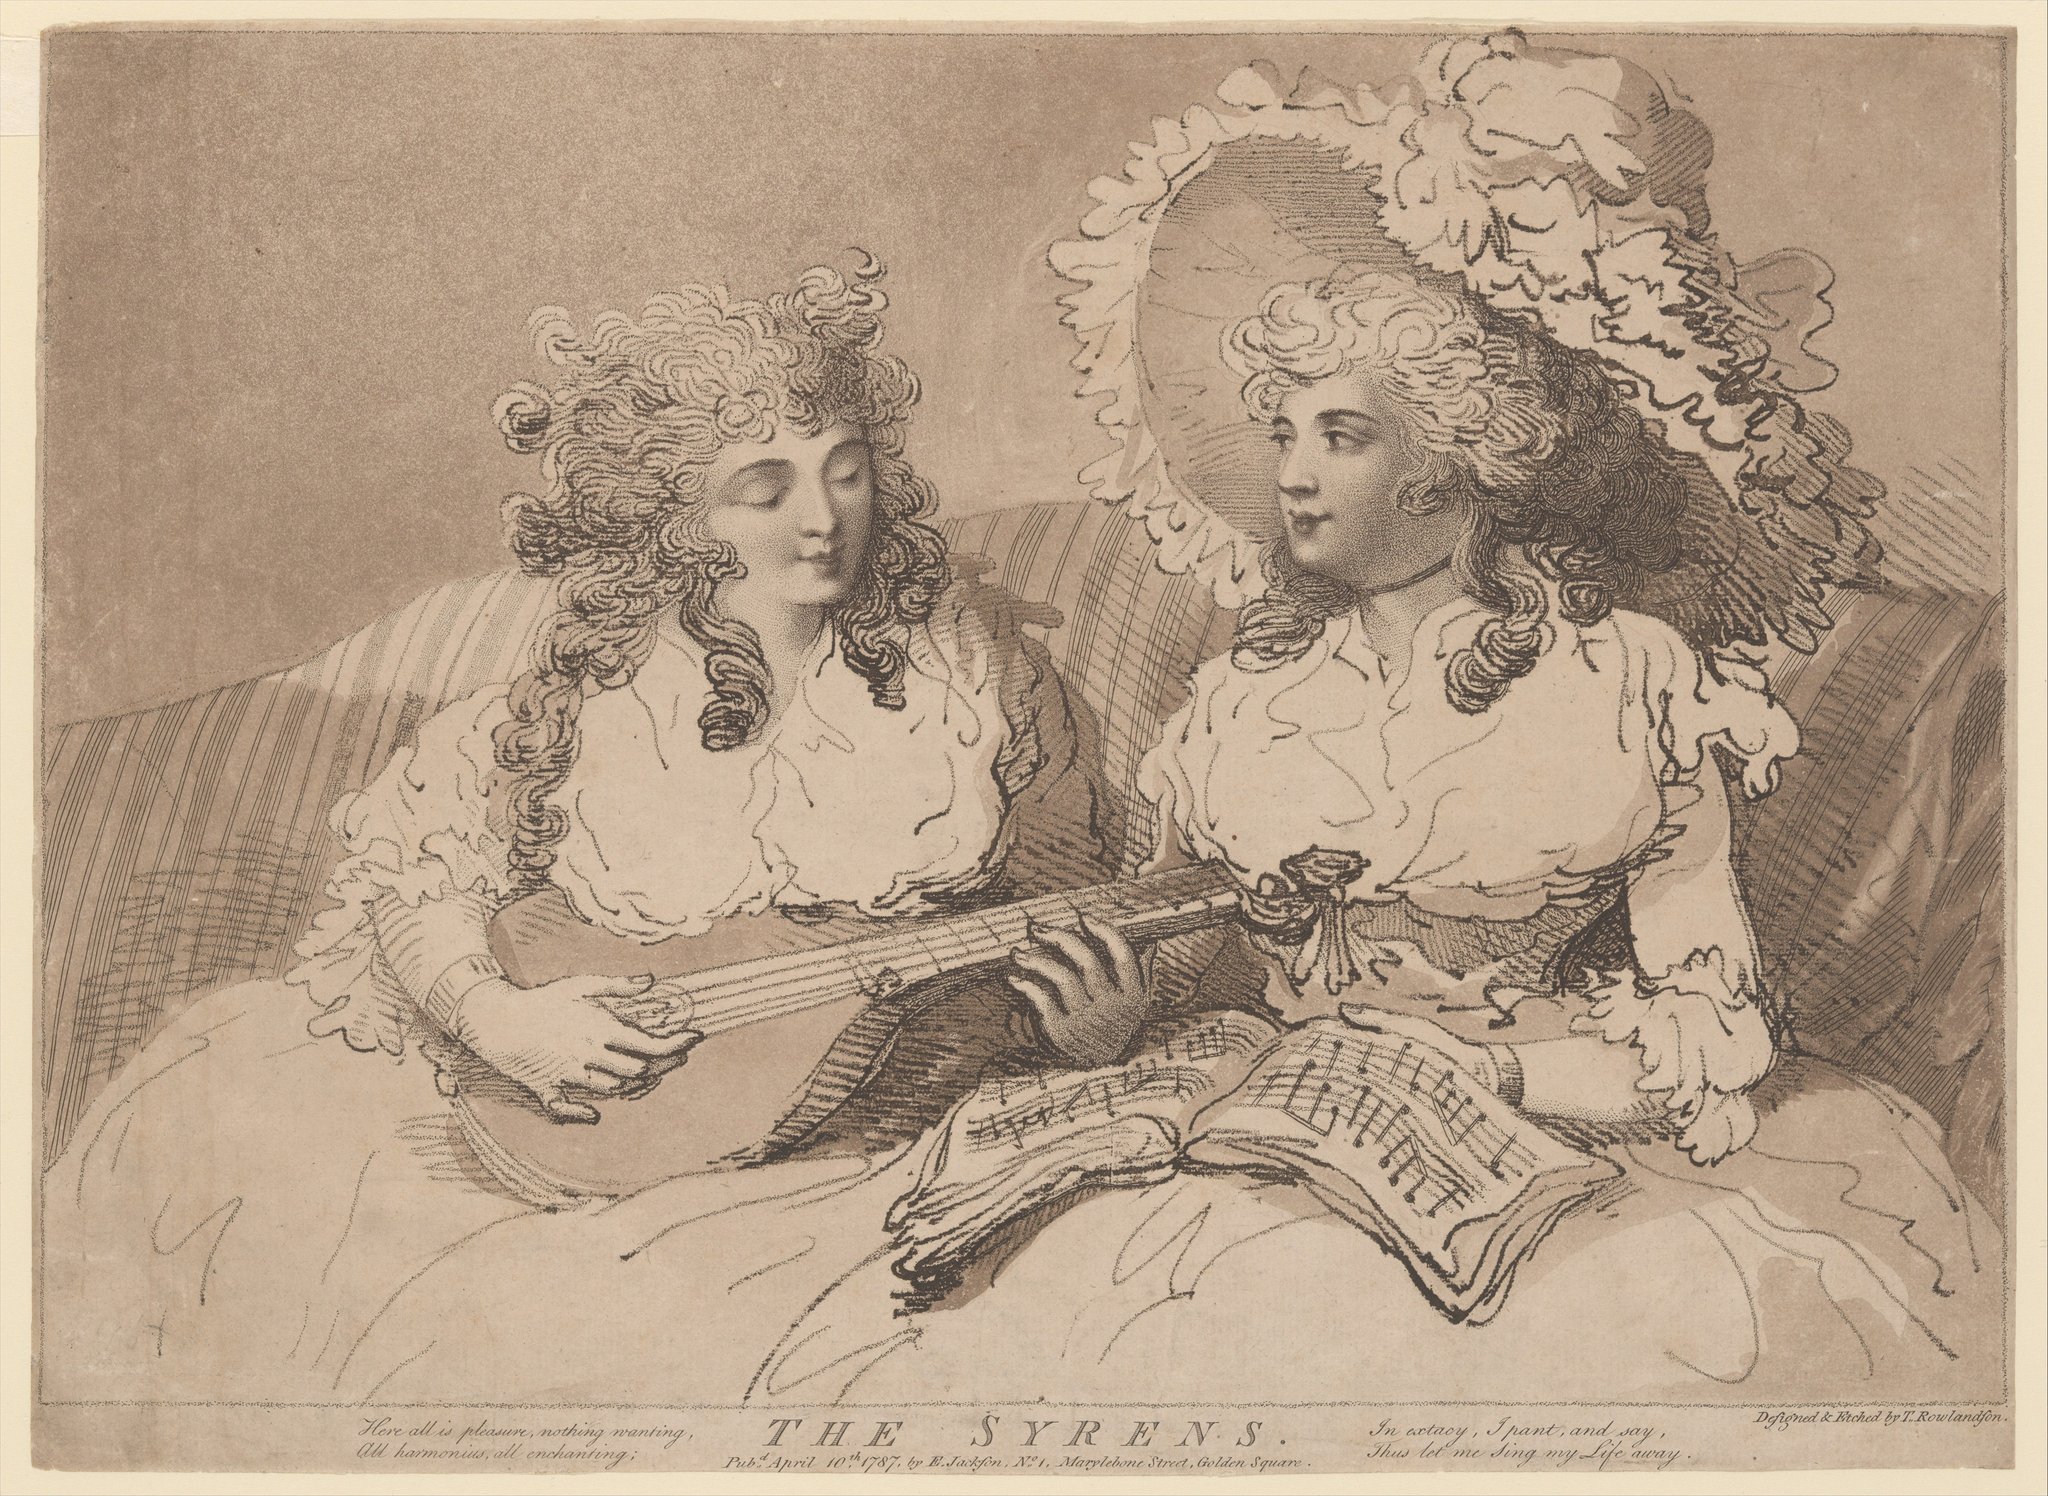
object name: print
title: The Syrens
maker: thomas rowlandson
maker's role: artist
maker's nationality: british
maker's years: 1757-1827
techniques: aquatint, etching, stippling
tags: women,music,lutes